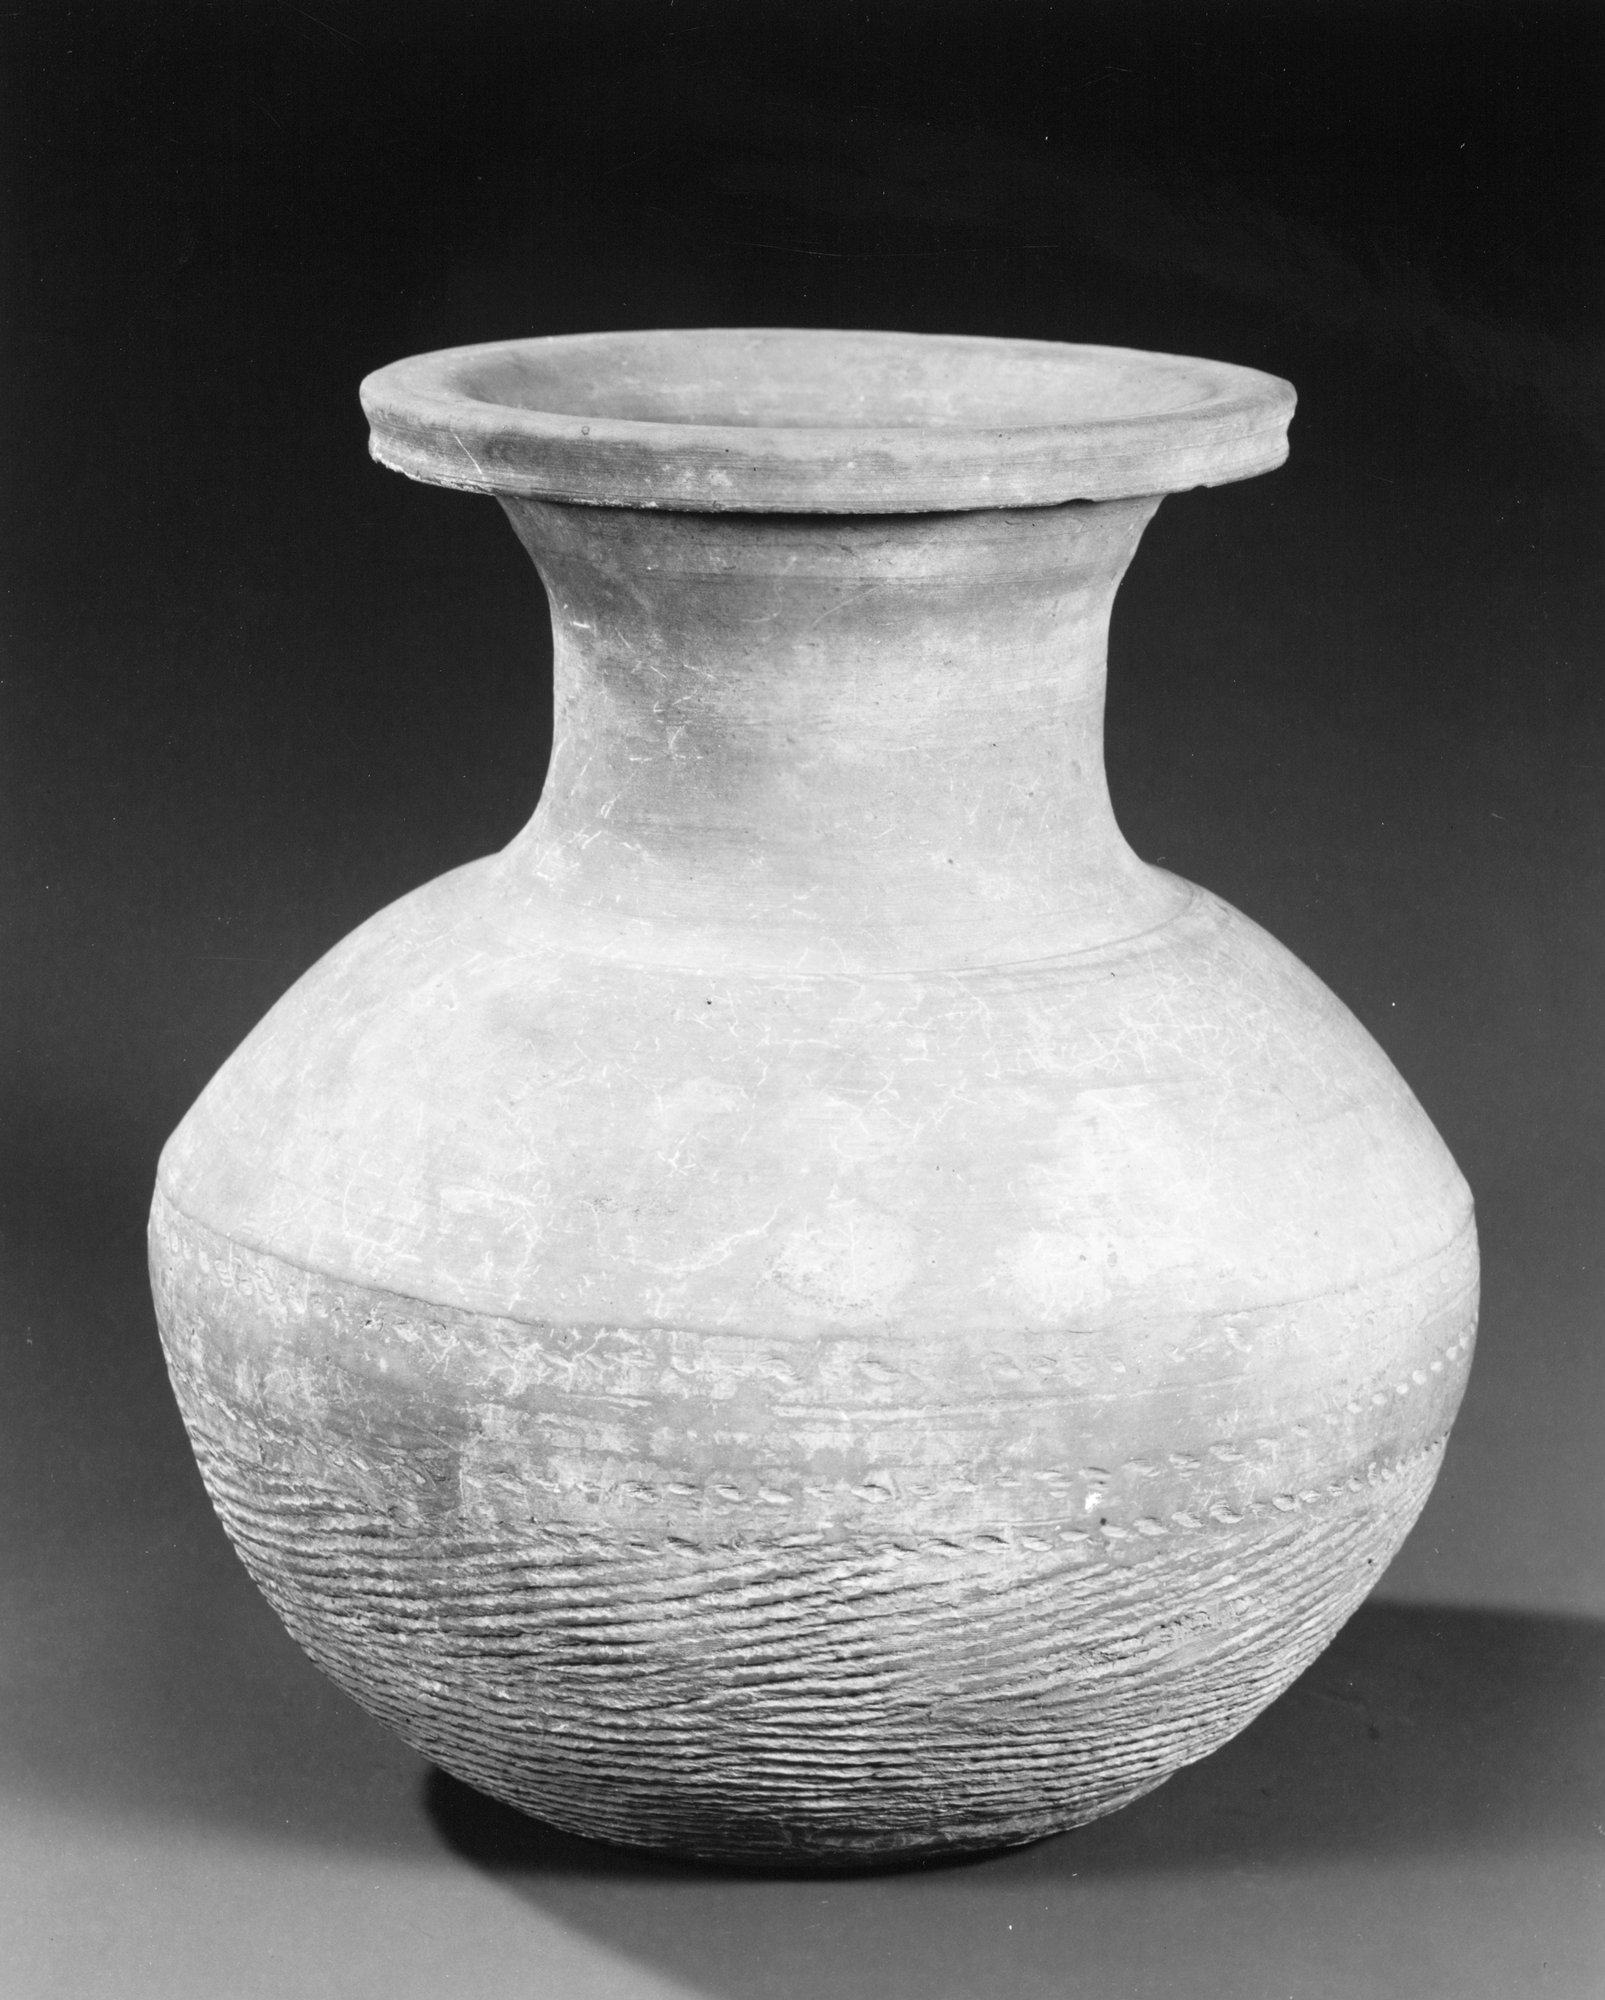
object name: jar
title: Jar (Hu)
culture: chinese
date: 500-201 BCE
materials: cord, earthenware